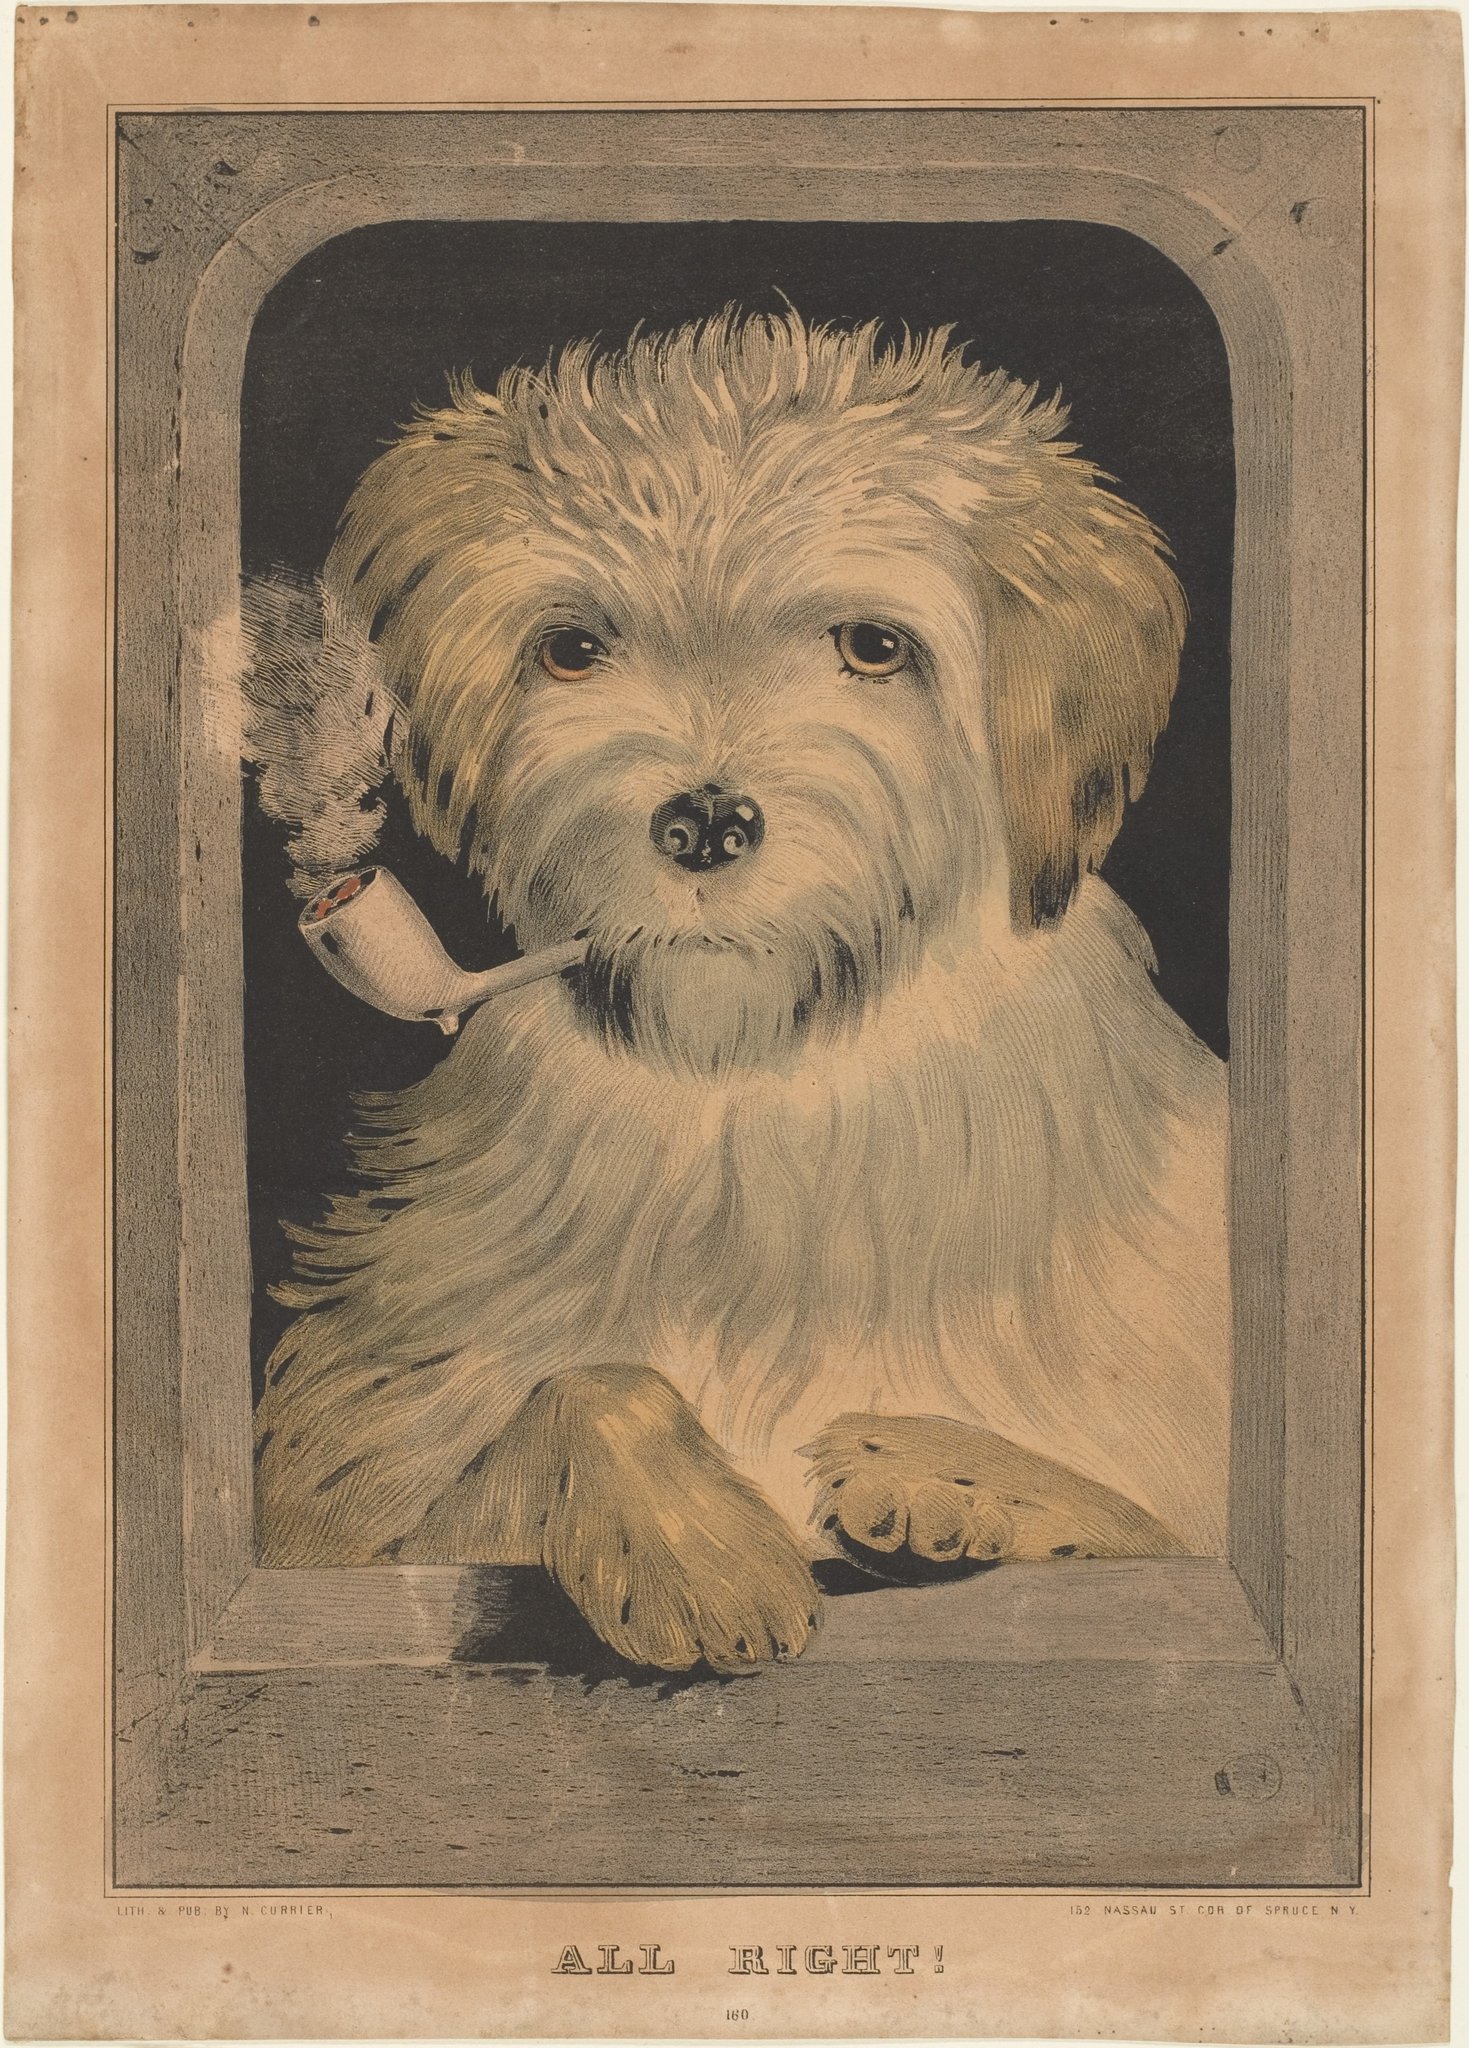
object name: print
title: All Right!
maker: nathaniel currier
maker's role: publisher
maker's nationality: american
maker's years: 1813-1888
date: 1846-1856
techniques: hand coloring, lithograph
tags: smoking,dogs,pipes